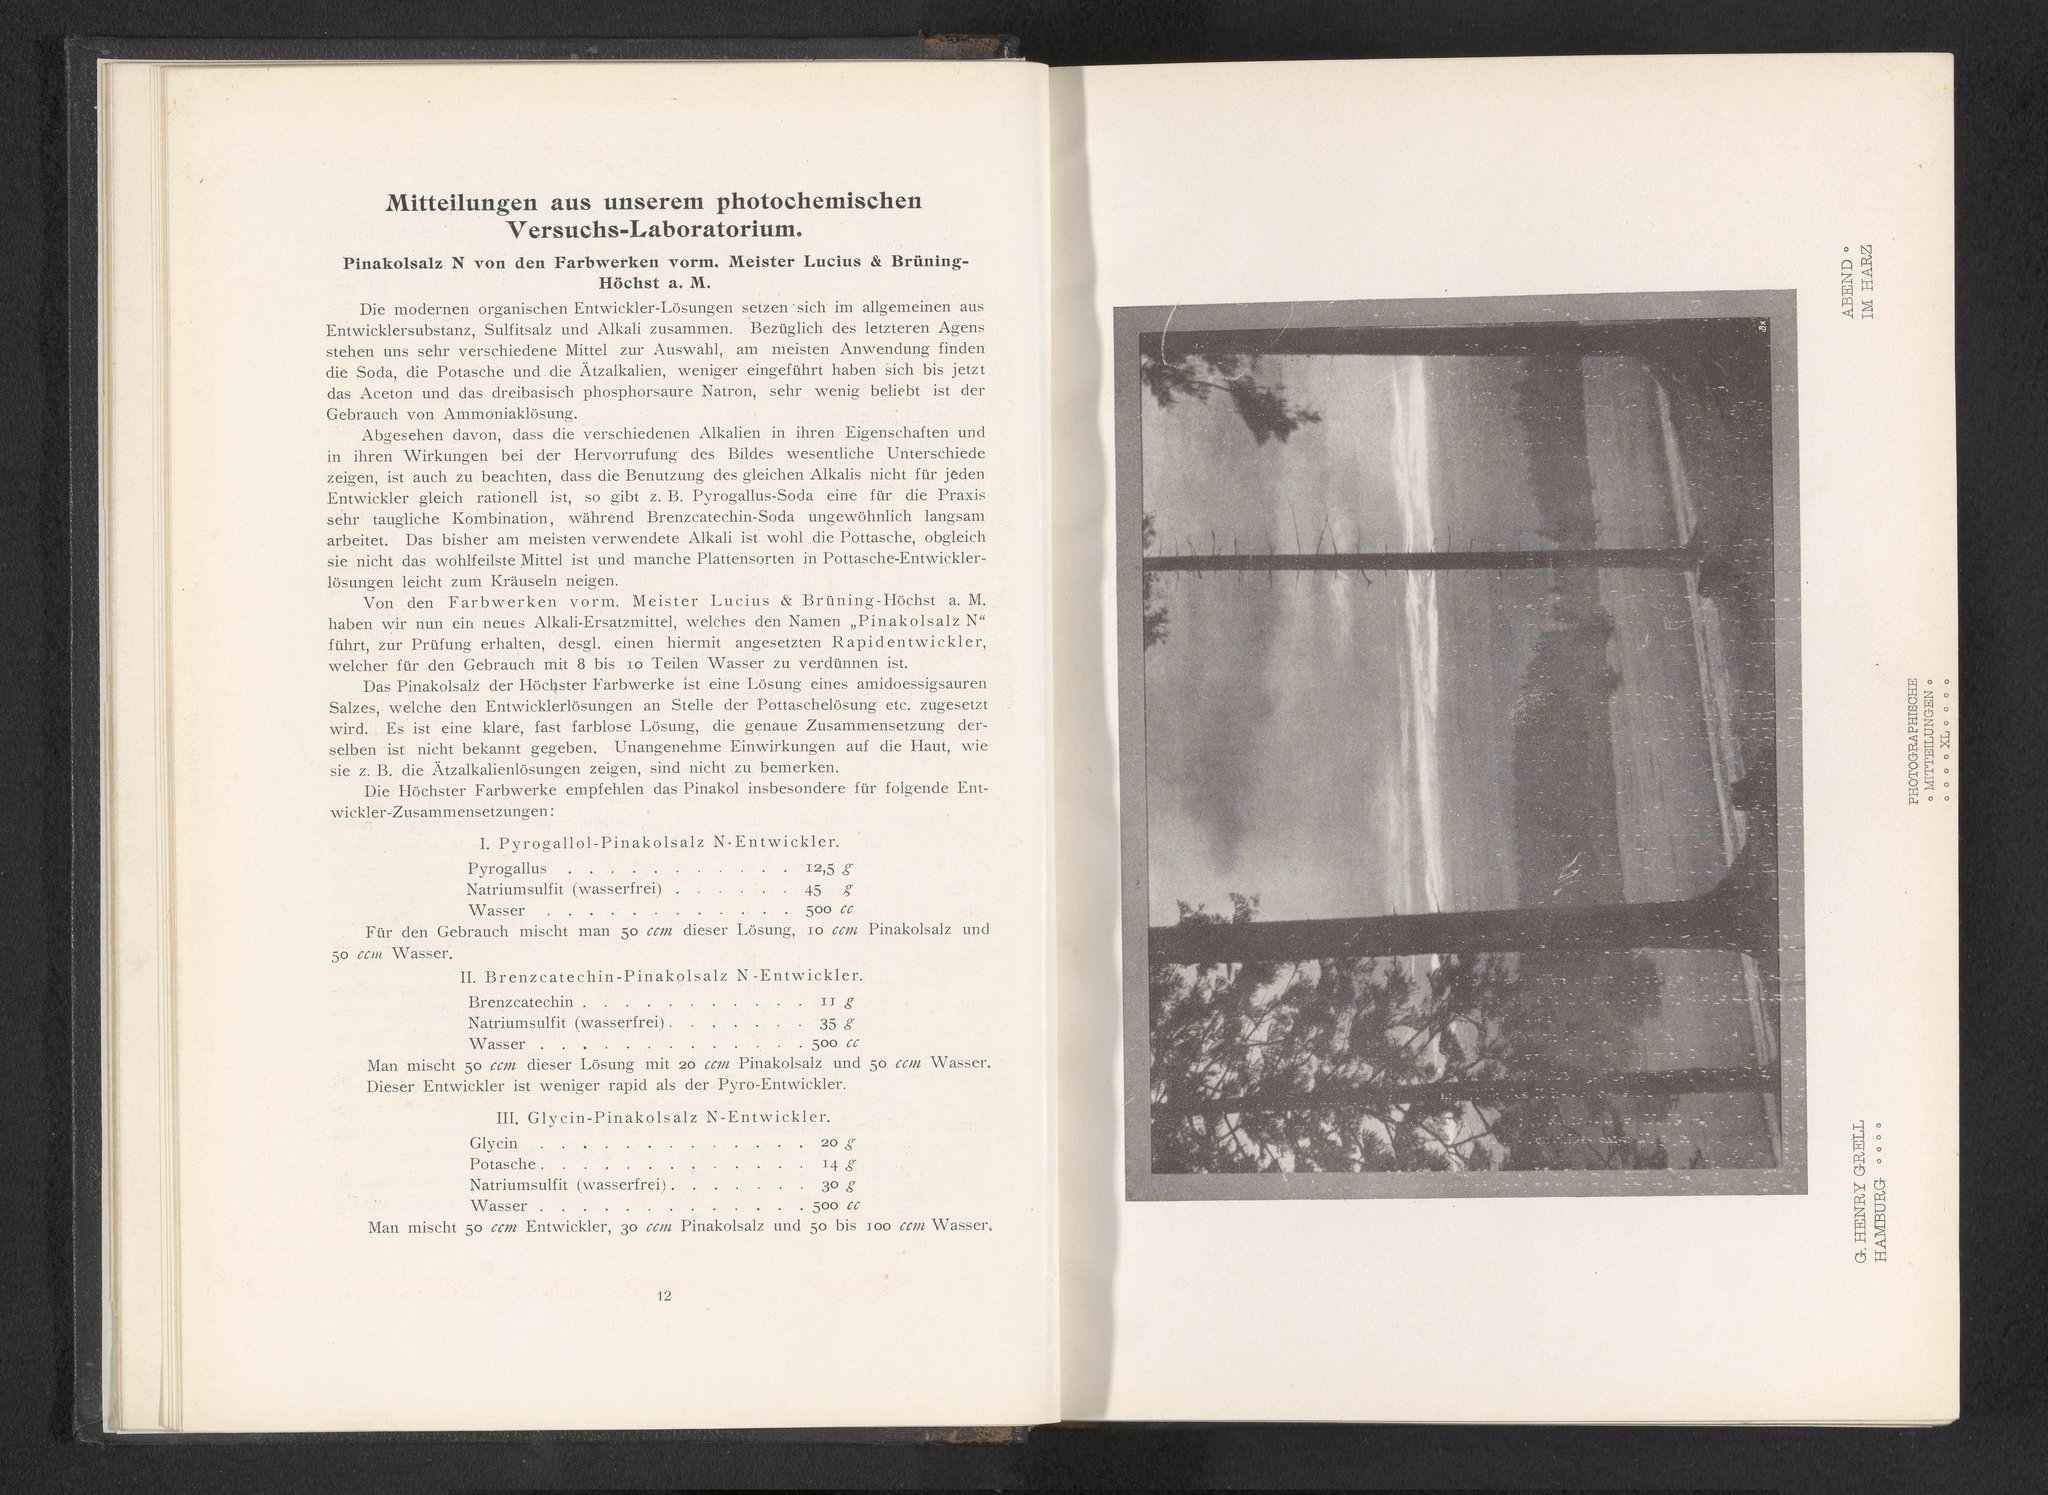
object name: photomechanical print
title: Zonsondergang in het Harzgebergte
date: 1898-1903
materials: paper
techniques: autotype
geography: harz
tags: landscapes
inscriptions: monogram: ‘BX’, inscription: ‘Photographische Mitteilungen XL’, inscription: ‘Hamburg’